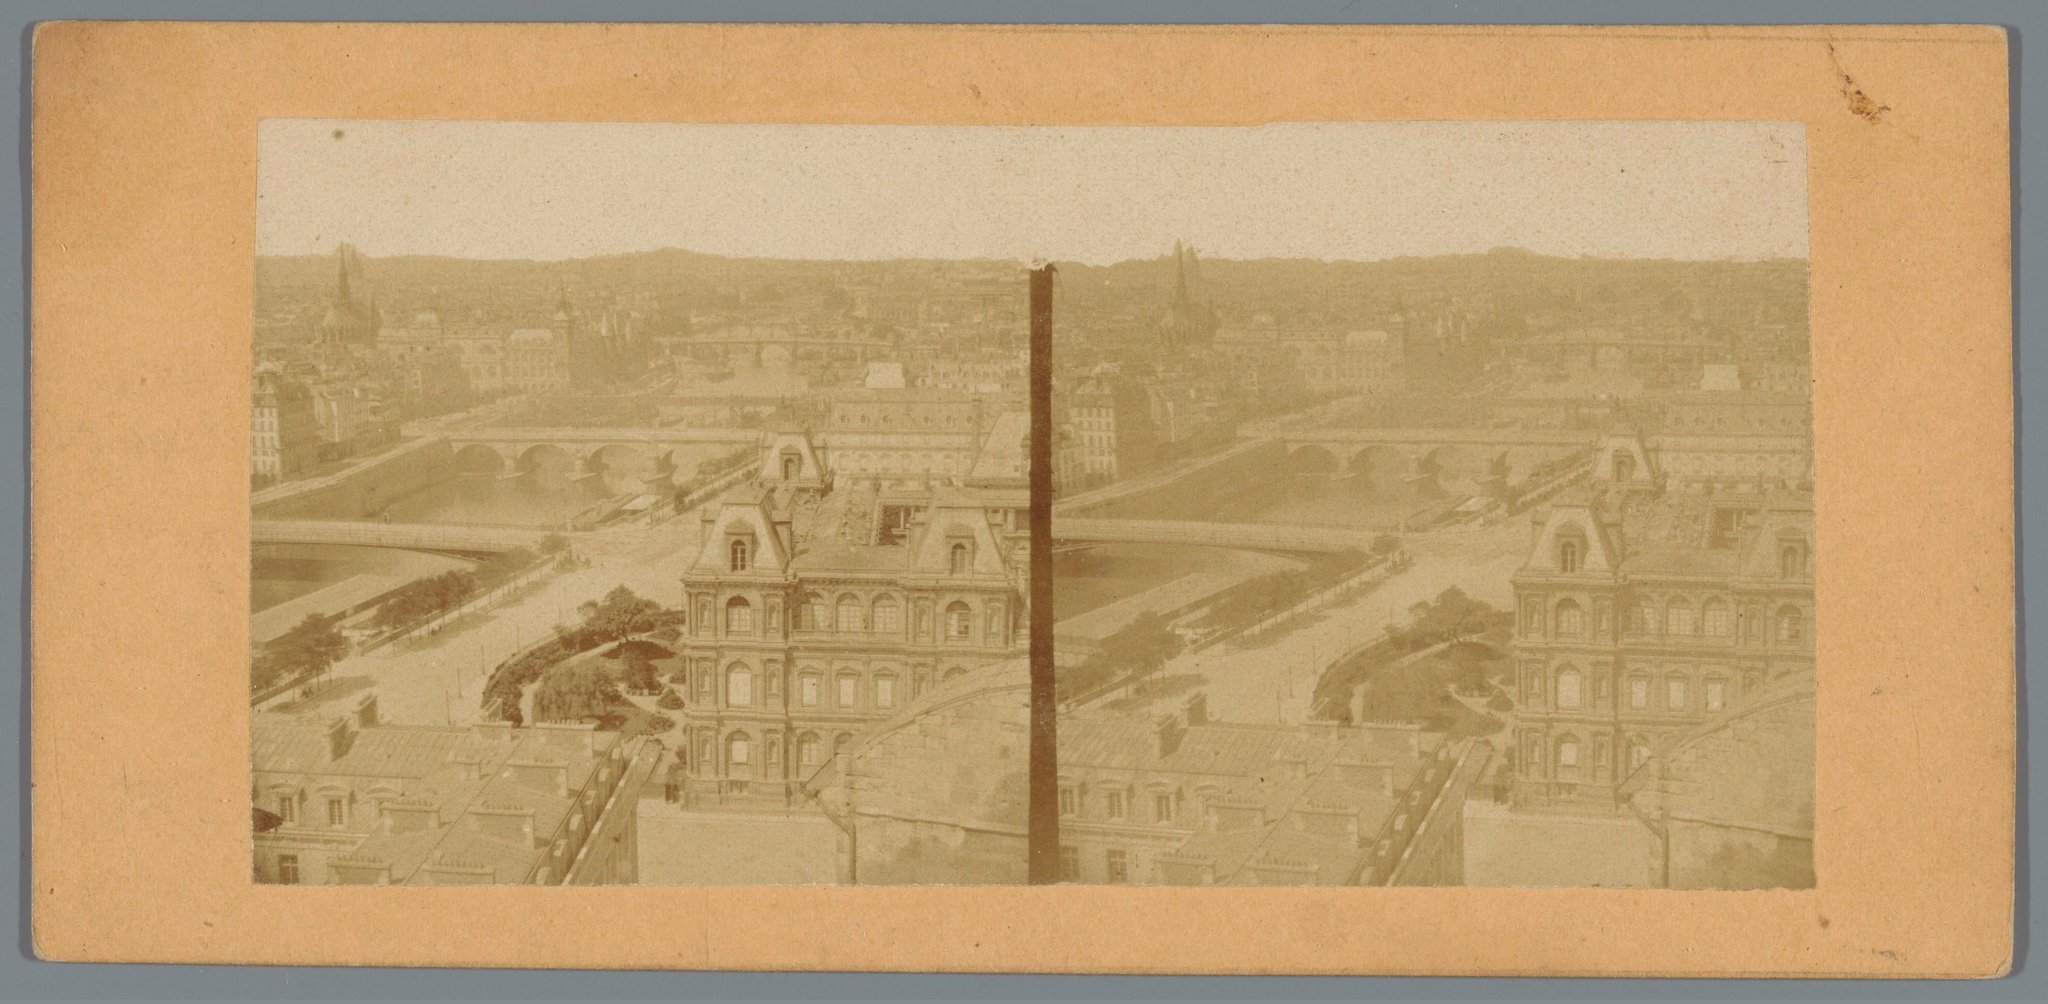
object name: stereograph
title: Gezicht op de Seine, verschillende bruggen en vermoedelijk de Quai de l'Hôtel-de-Ville in Parijs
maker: Anonymous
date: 1850-1880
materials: cardboard, photographic support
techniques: albumen print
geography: paris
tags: bridge in city across river, canal, etc., paris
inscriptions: inscription: ‘Vue sur les Sept Ponts (Paris) 1862-1864.-1867-1881-1883.-1887.-1889.’